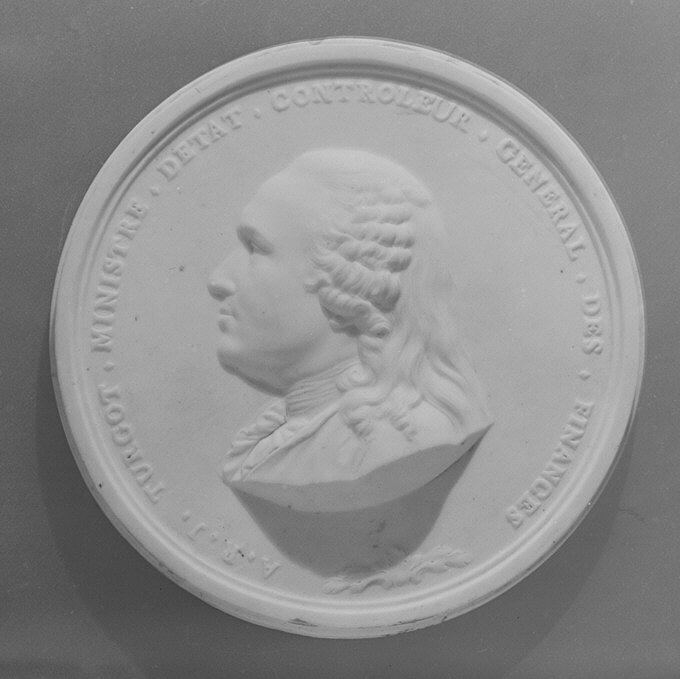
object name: medallion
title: Anne-Robert-Jacques Turgot, Baron de l'Aulne (1727–1781)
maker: comte d'artois, later charles x of france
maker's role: factory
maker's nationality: french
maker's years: 1757-1839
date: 1774-1776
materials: biscuit, paste, porcelain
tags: men,profiles